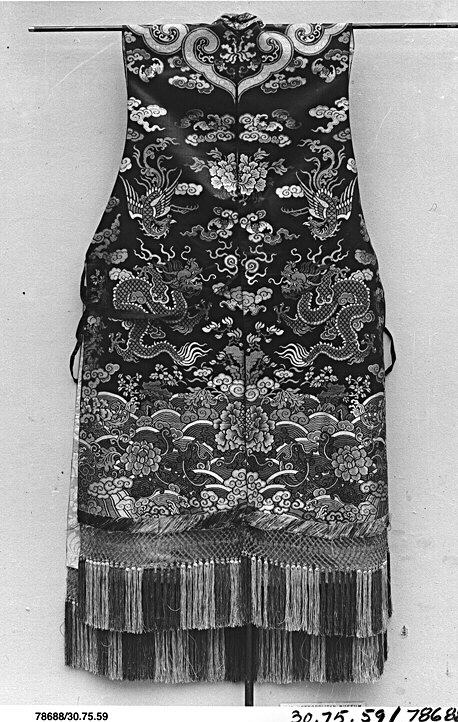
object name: woman's vest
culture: chinese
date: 1767-1833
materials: silk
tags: dragons,phoenix